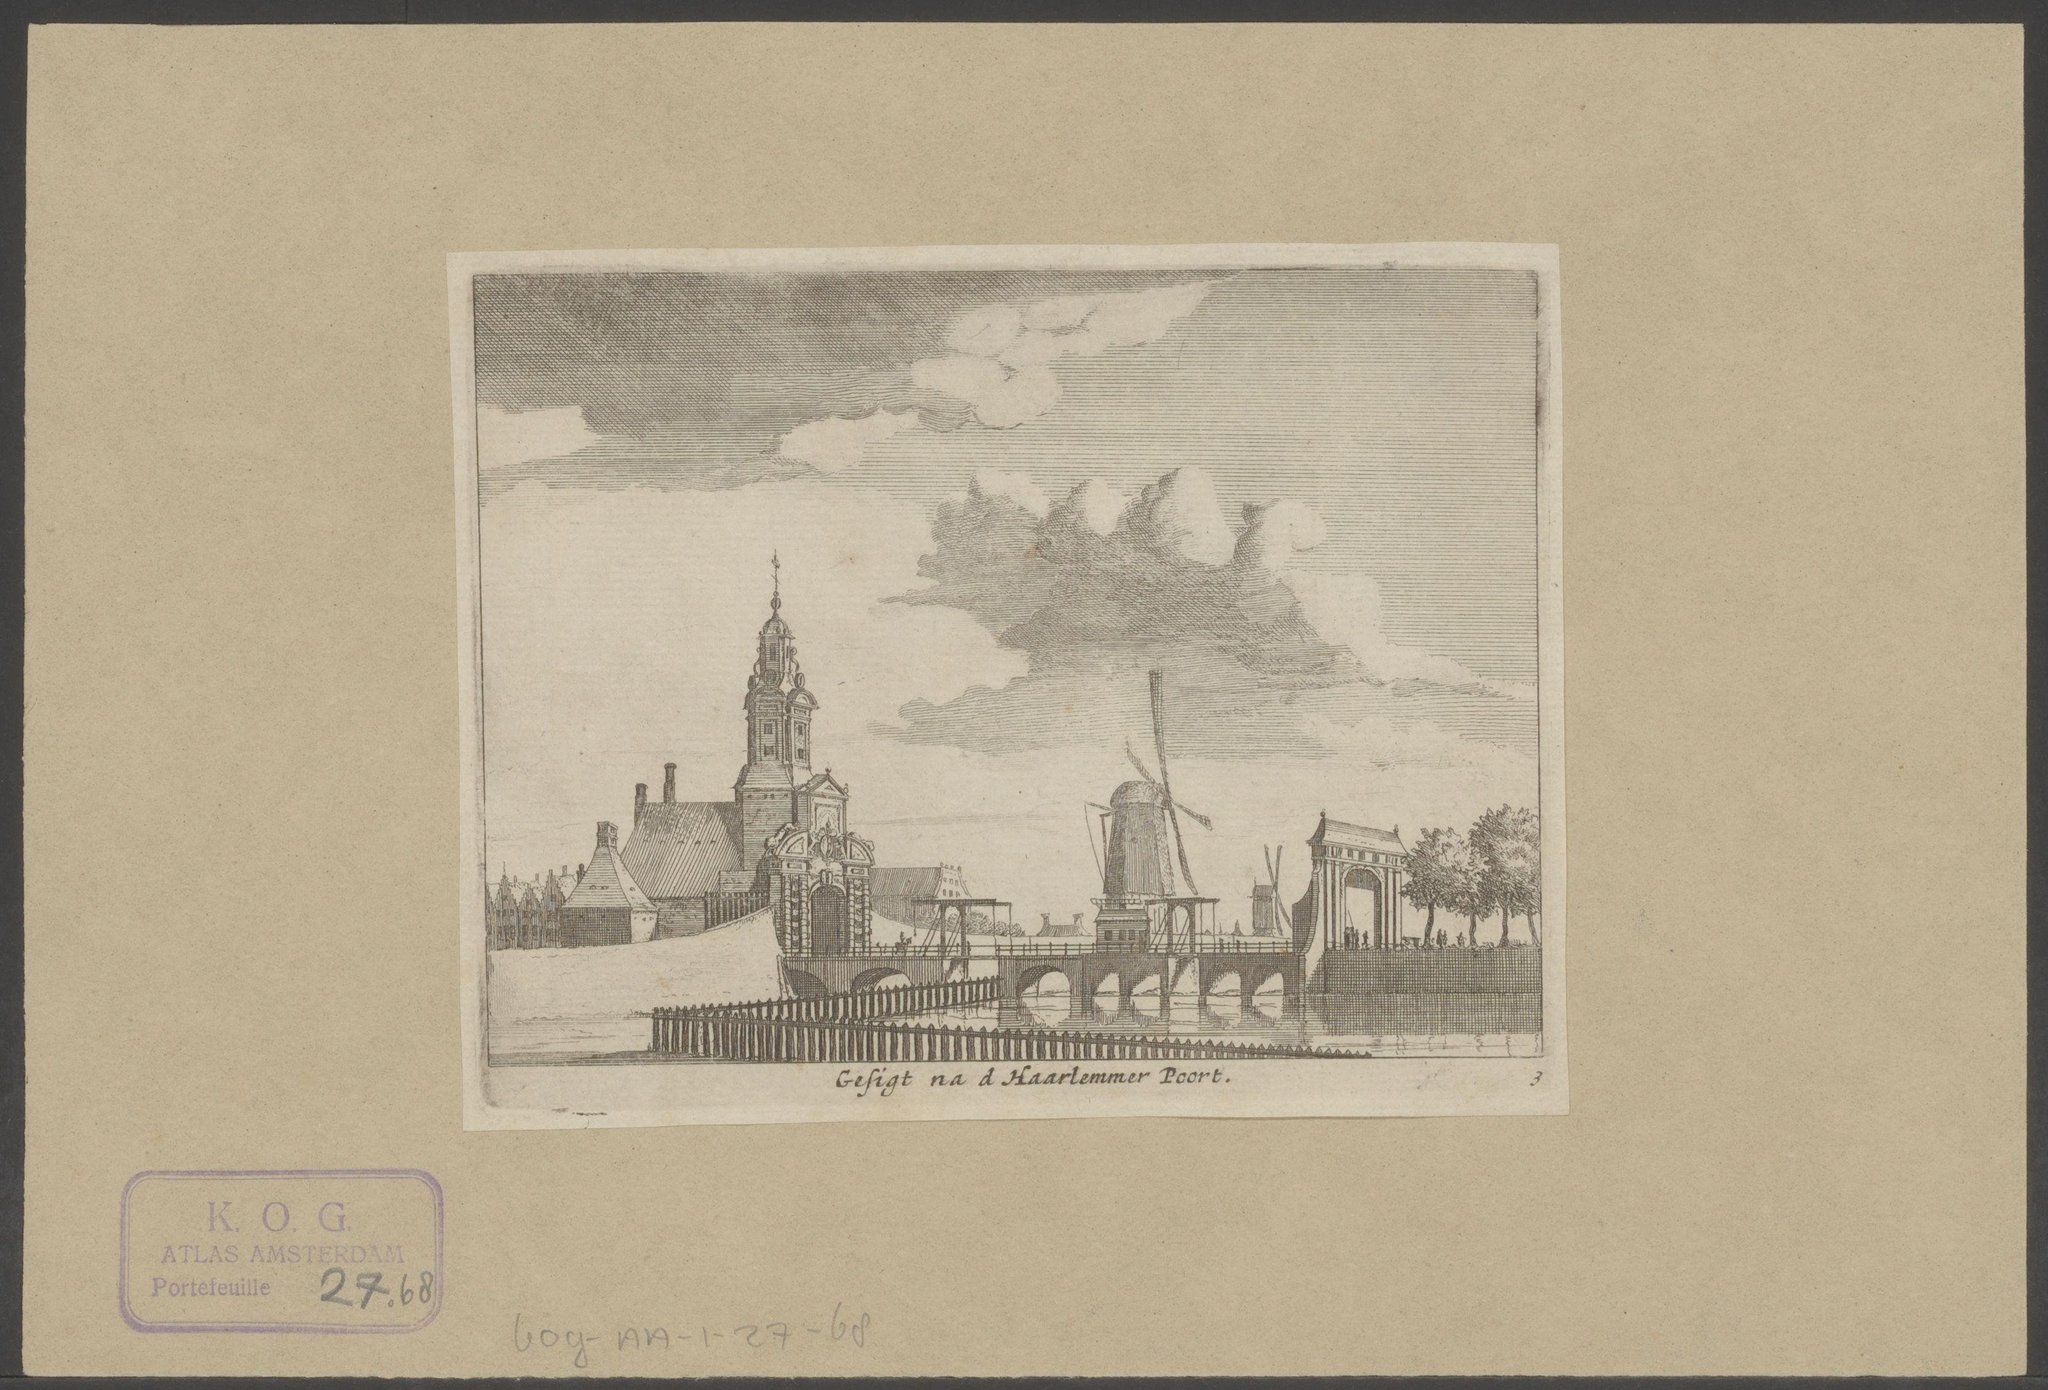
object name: print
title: Gesigt na d Haarlemmer Poort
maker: Anonymous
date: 1700-1749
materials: paper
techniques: engraving, etching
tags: rowing-boat, canoe, etc., bridge in city across river, canal, etc.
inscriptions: collector's mark: Lugt 1641b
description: Rechtsonder genummerd: 3. Onderwerpsrubriek binnen de Atlas Amsterdam: B. Poorten, verzamelbladen, D. Haarlemmerpoort(en).